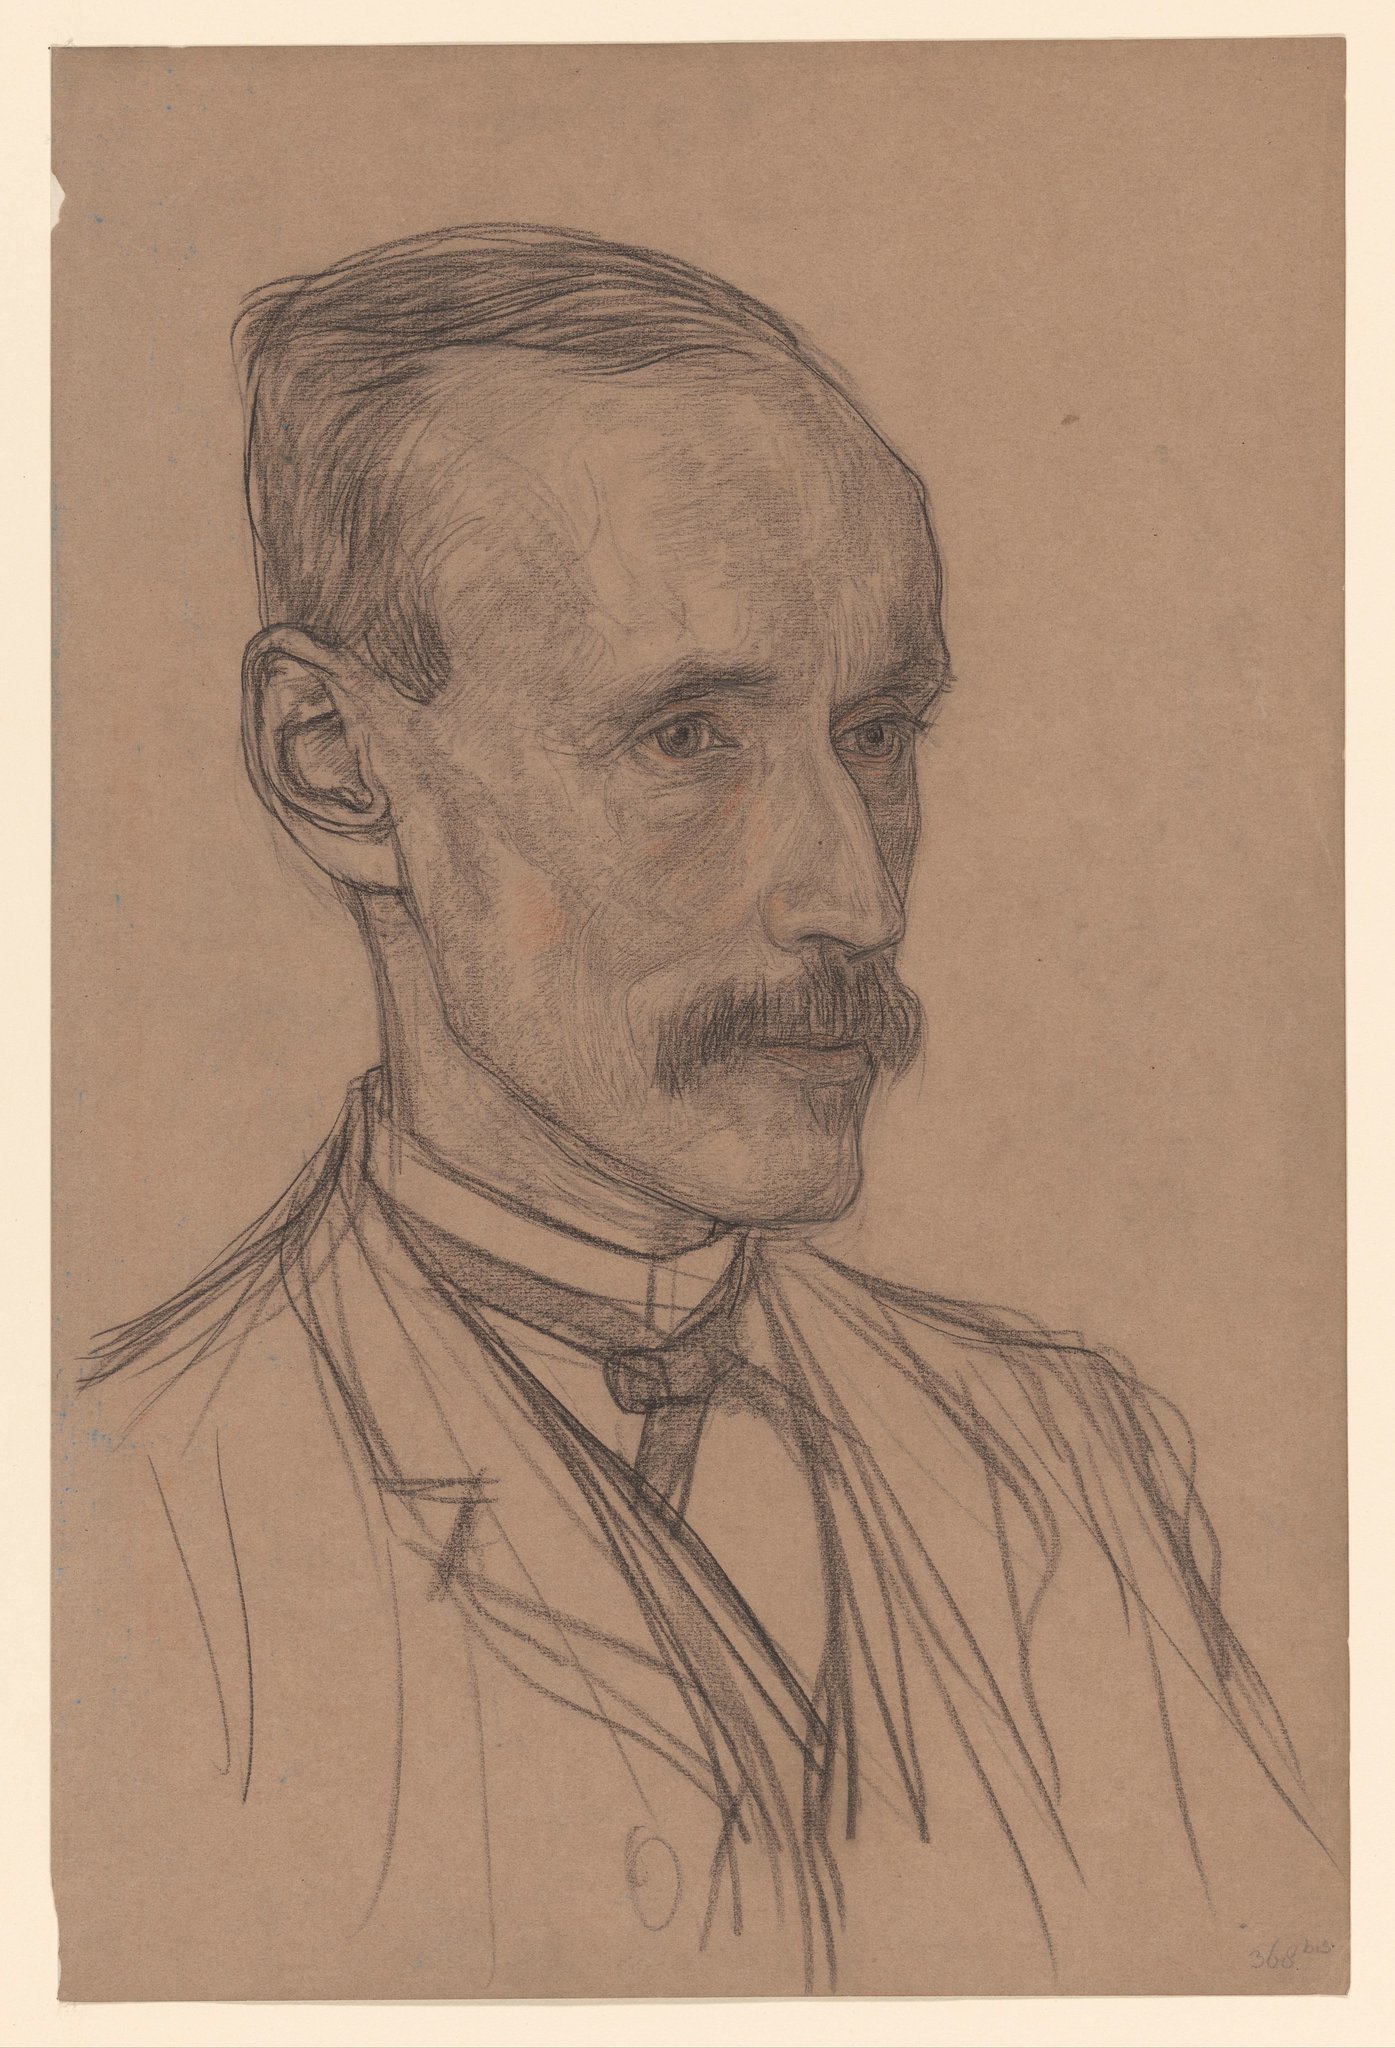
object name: drawing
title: Portret van Allard Pierson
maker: jan veth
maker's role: designer, draughtsman, painter, print maker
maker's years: 1864-1925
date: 1874-1925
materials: chalk, paper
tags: amsterdam, allard pierson, historical persons